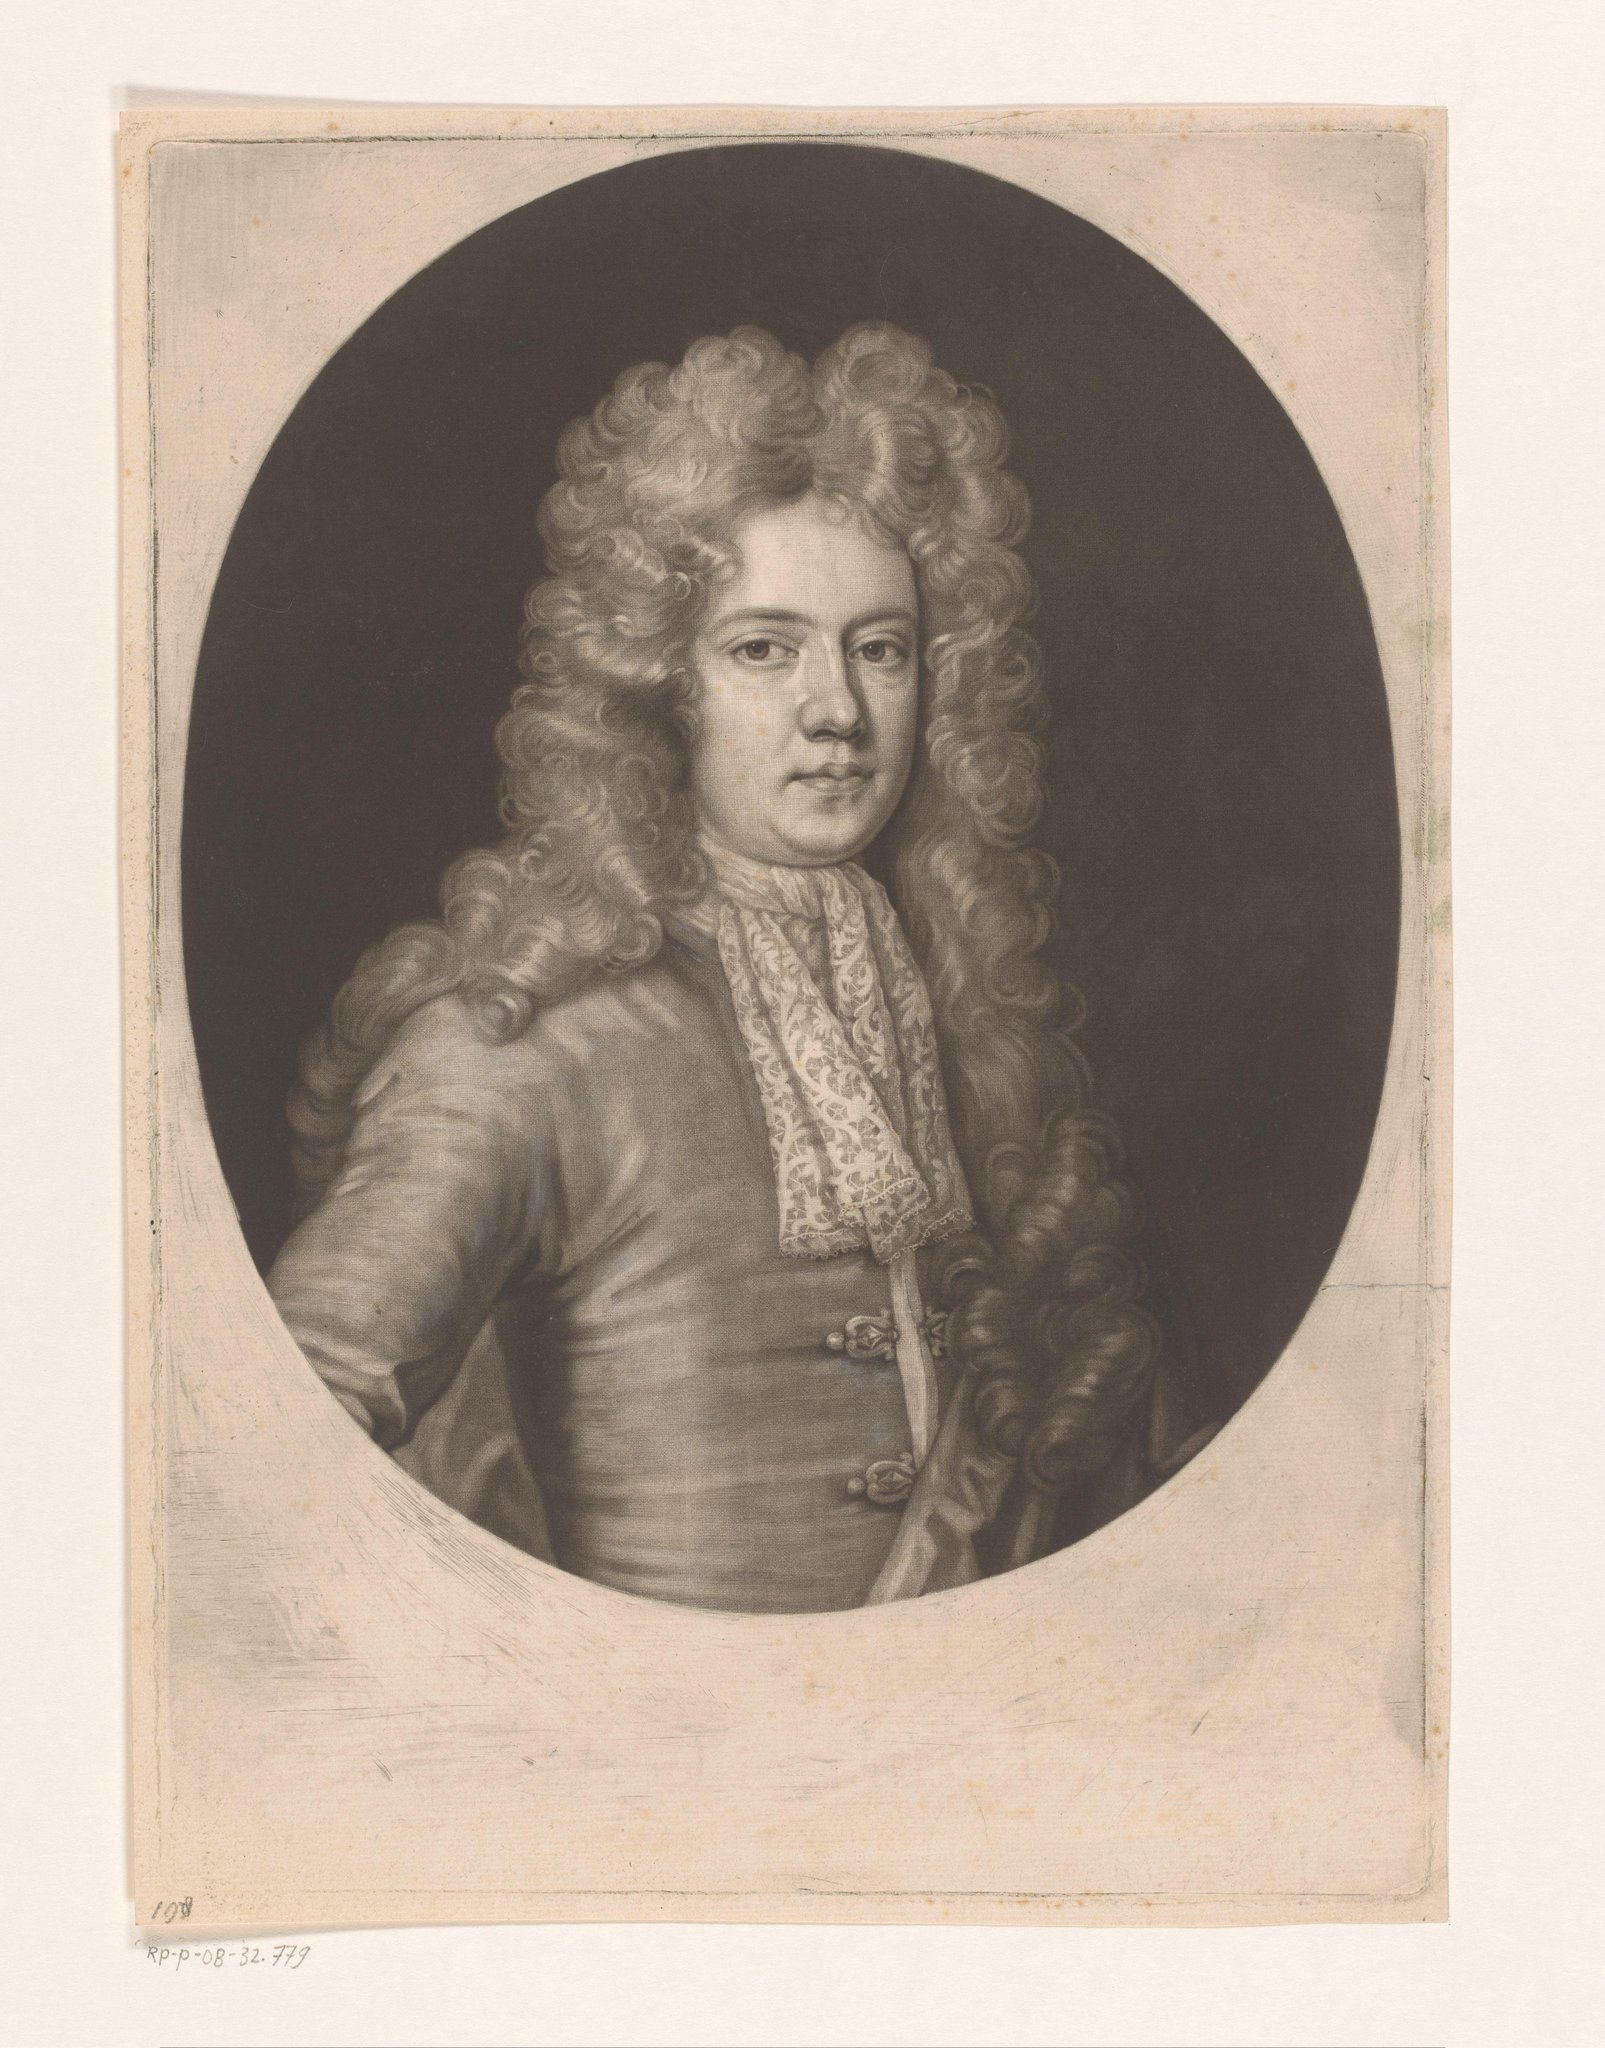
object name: print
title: Portret van Devereux Knightley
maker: john smith (prentmaker/ uitgever)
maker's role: print maker, publisher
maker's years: 1652-1743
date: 1695-1742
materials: paper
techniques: mezzotint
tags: historical persons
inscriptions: collector's mark: Lugt 240